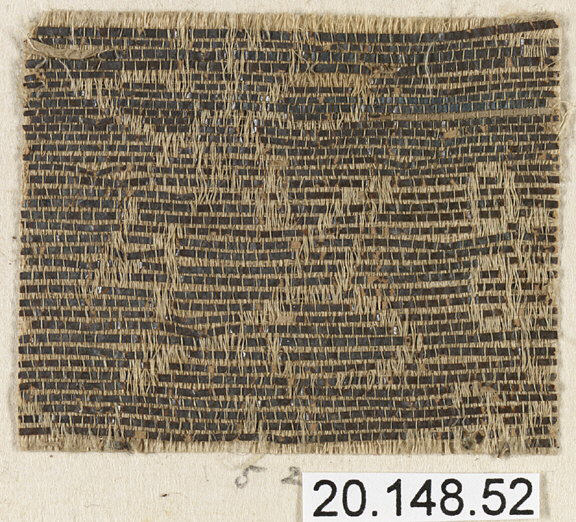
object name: piece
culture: japanese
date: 1501-1600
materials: silk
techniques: compound weave